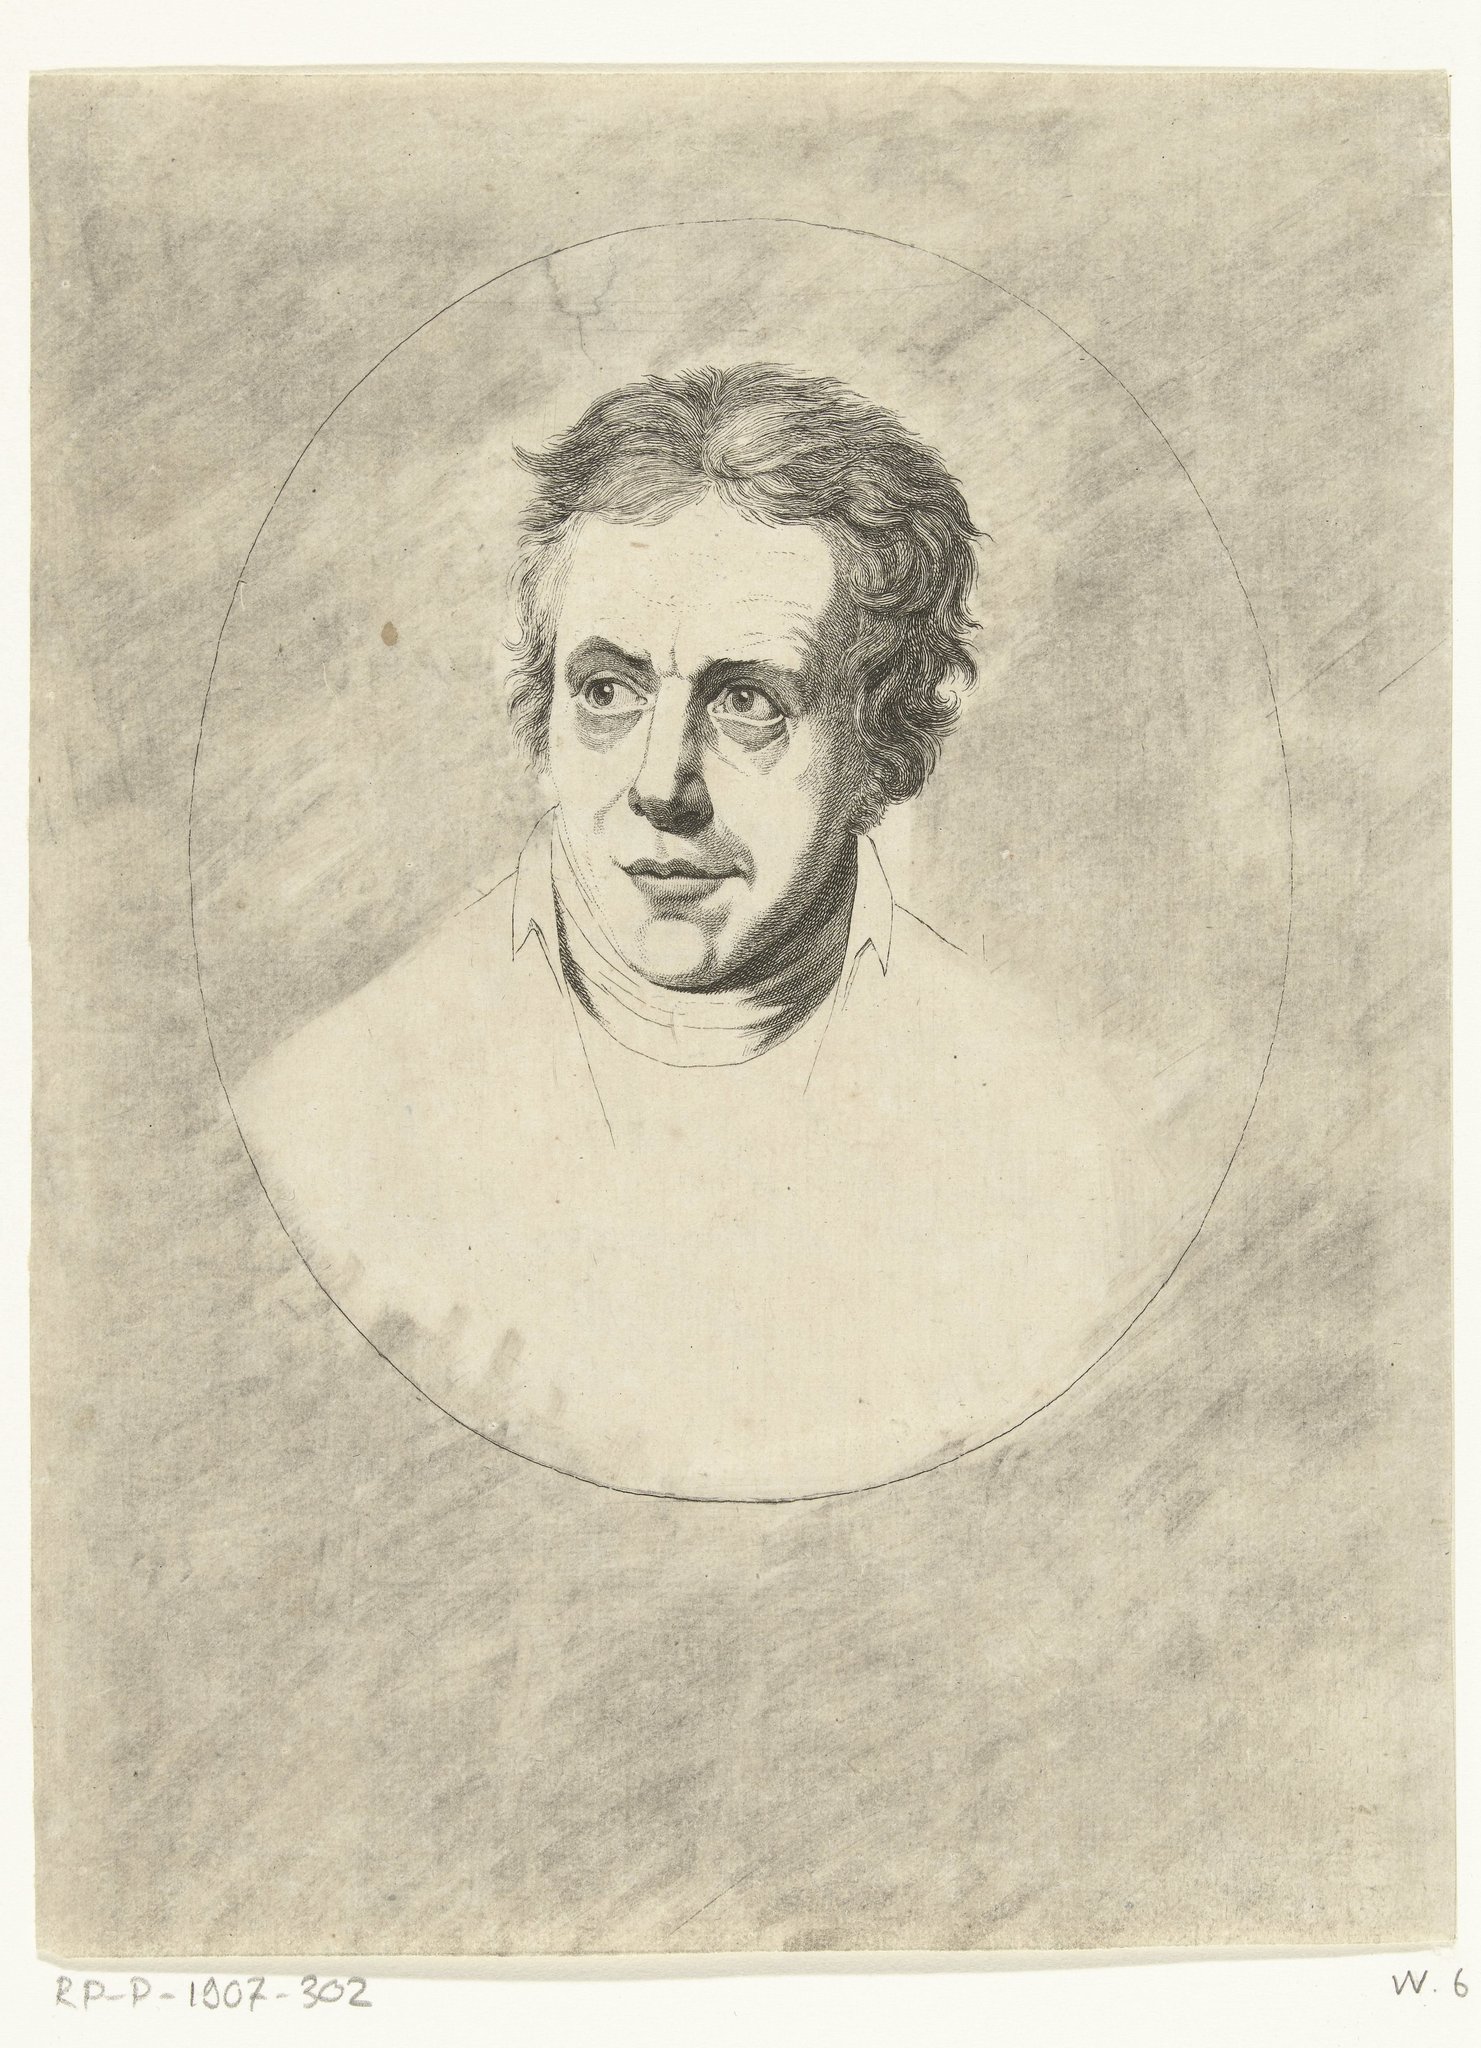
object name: print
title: Portret van Dirk Langendijk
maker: joannes bemme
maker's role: print maker, printer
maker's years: 1775-1841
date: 1805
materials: charcoal, paper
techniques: etching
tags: painter, draughtsman, dirk langendijk, art (+ portrait, self-portrait of artist)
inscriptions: collector's mark: Lugt 2228